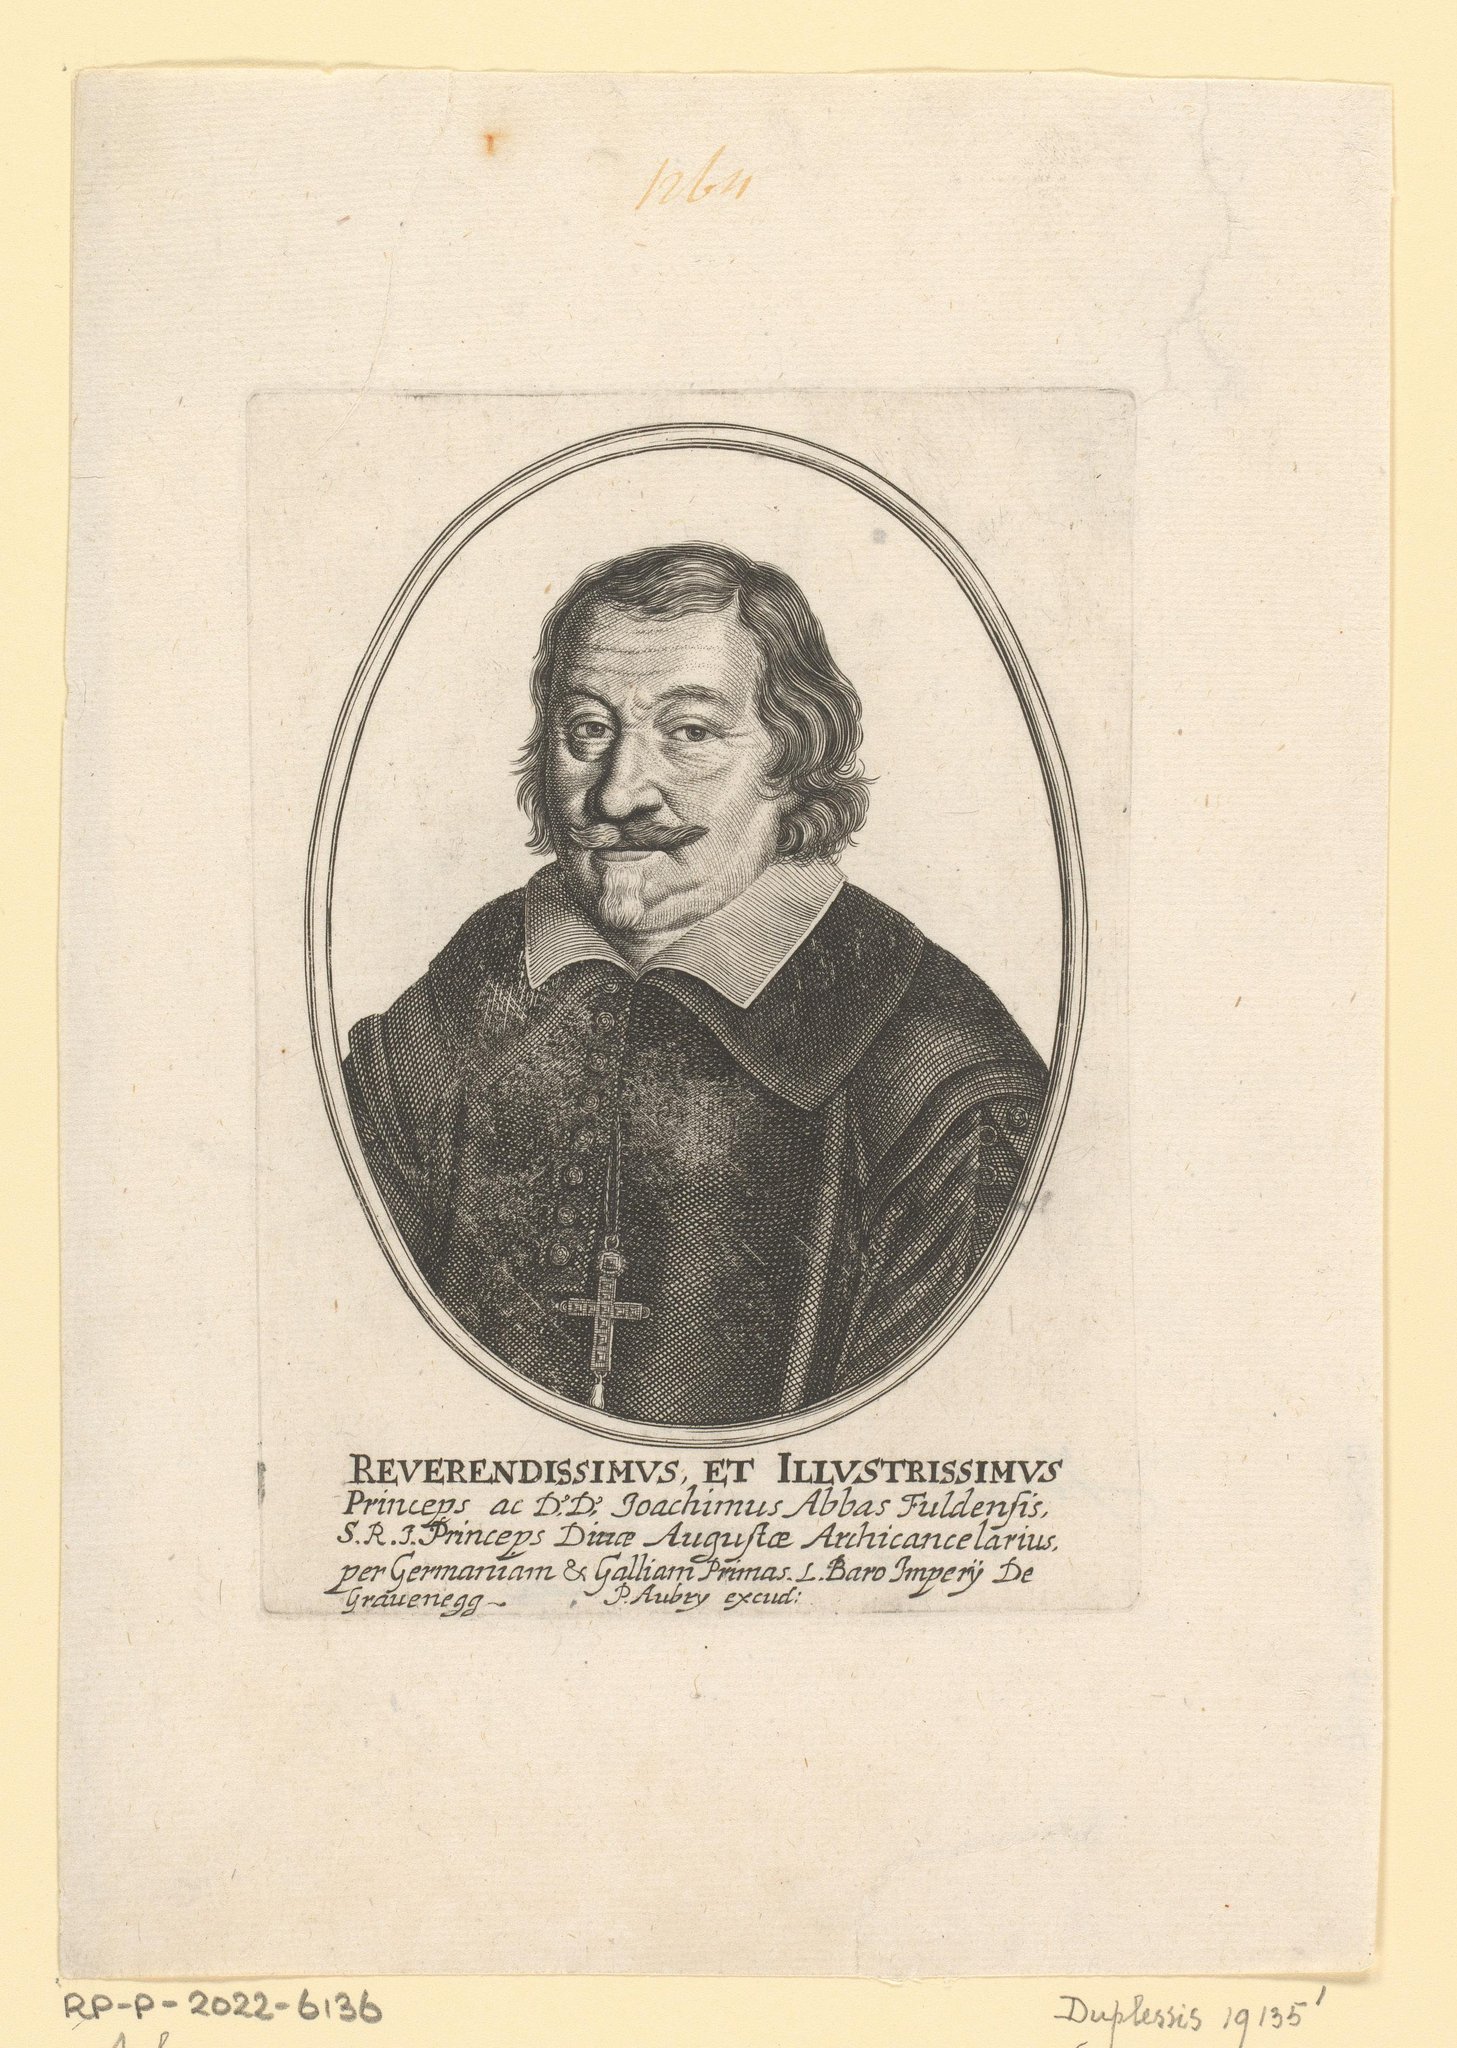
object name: print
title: Portret van Joachim von Gravenegg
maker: Anonymous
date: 1644-1686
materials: paper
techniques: engraving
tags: historical persons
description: Met vijfregelig onderschrift in het Latijn.